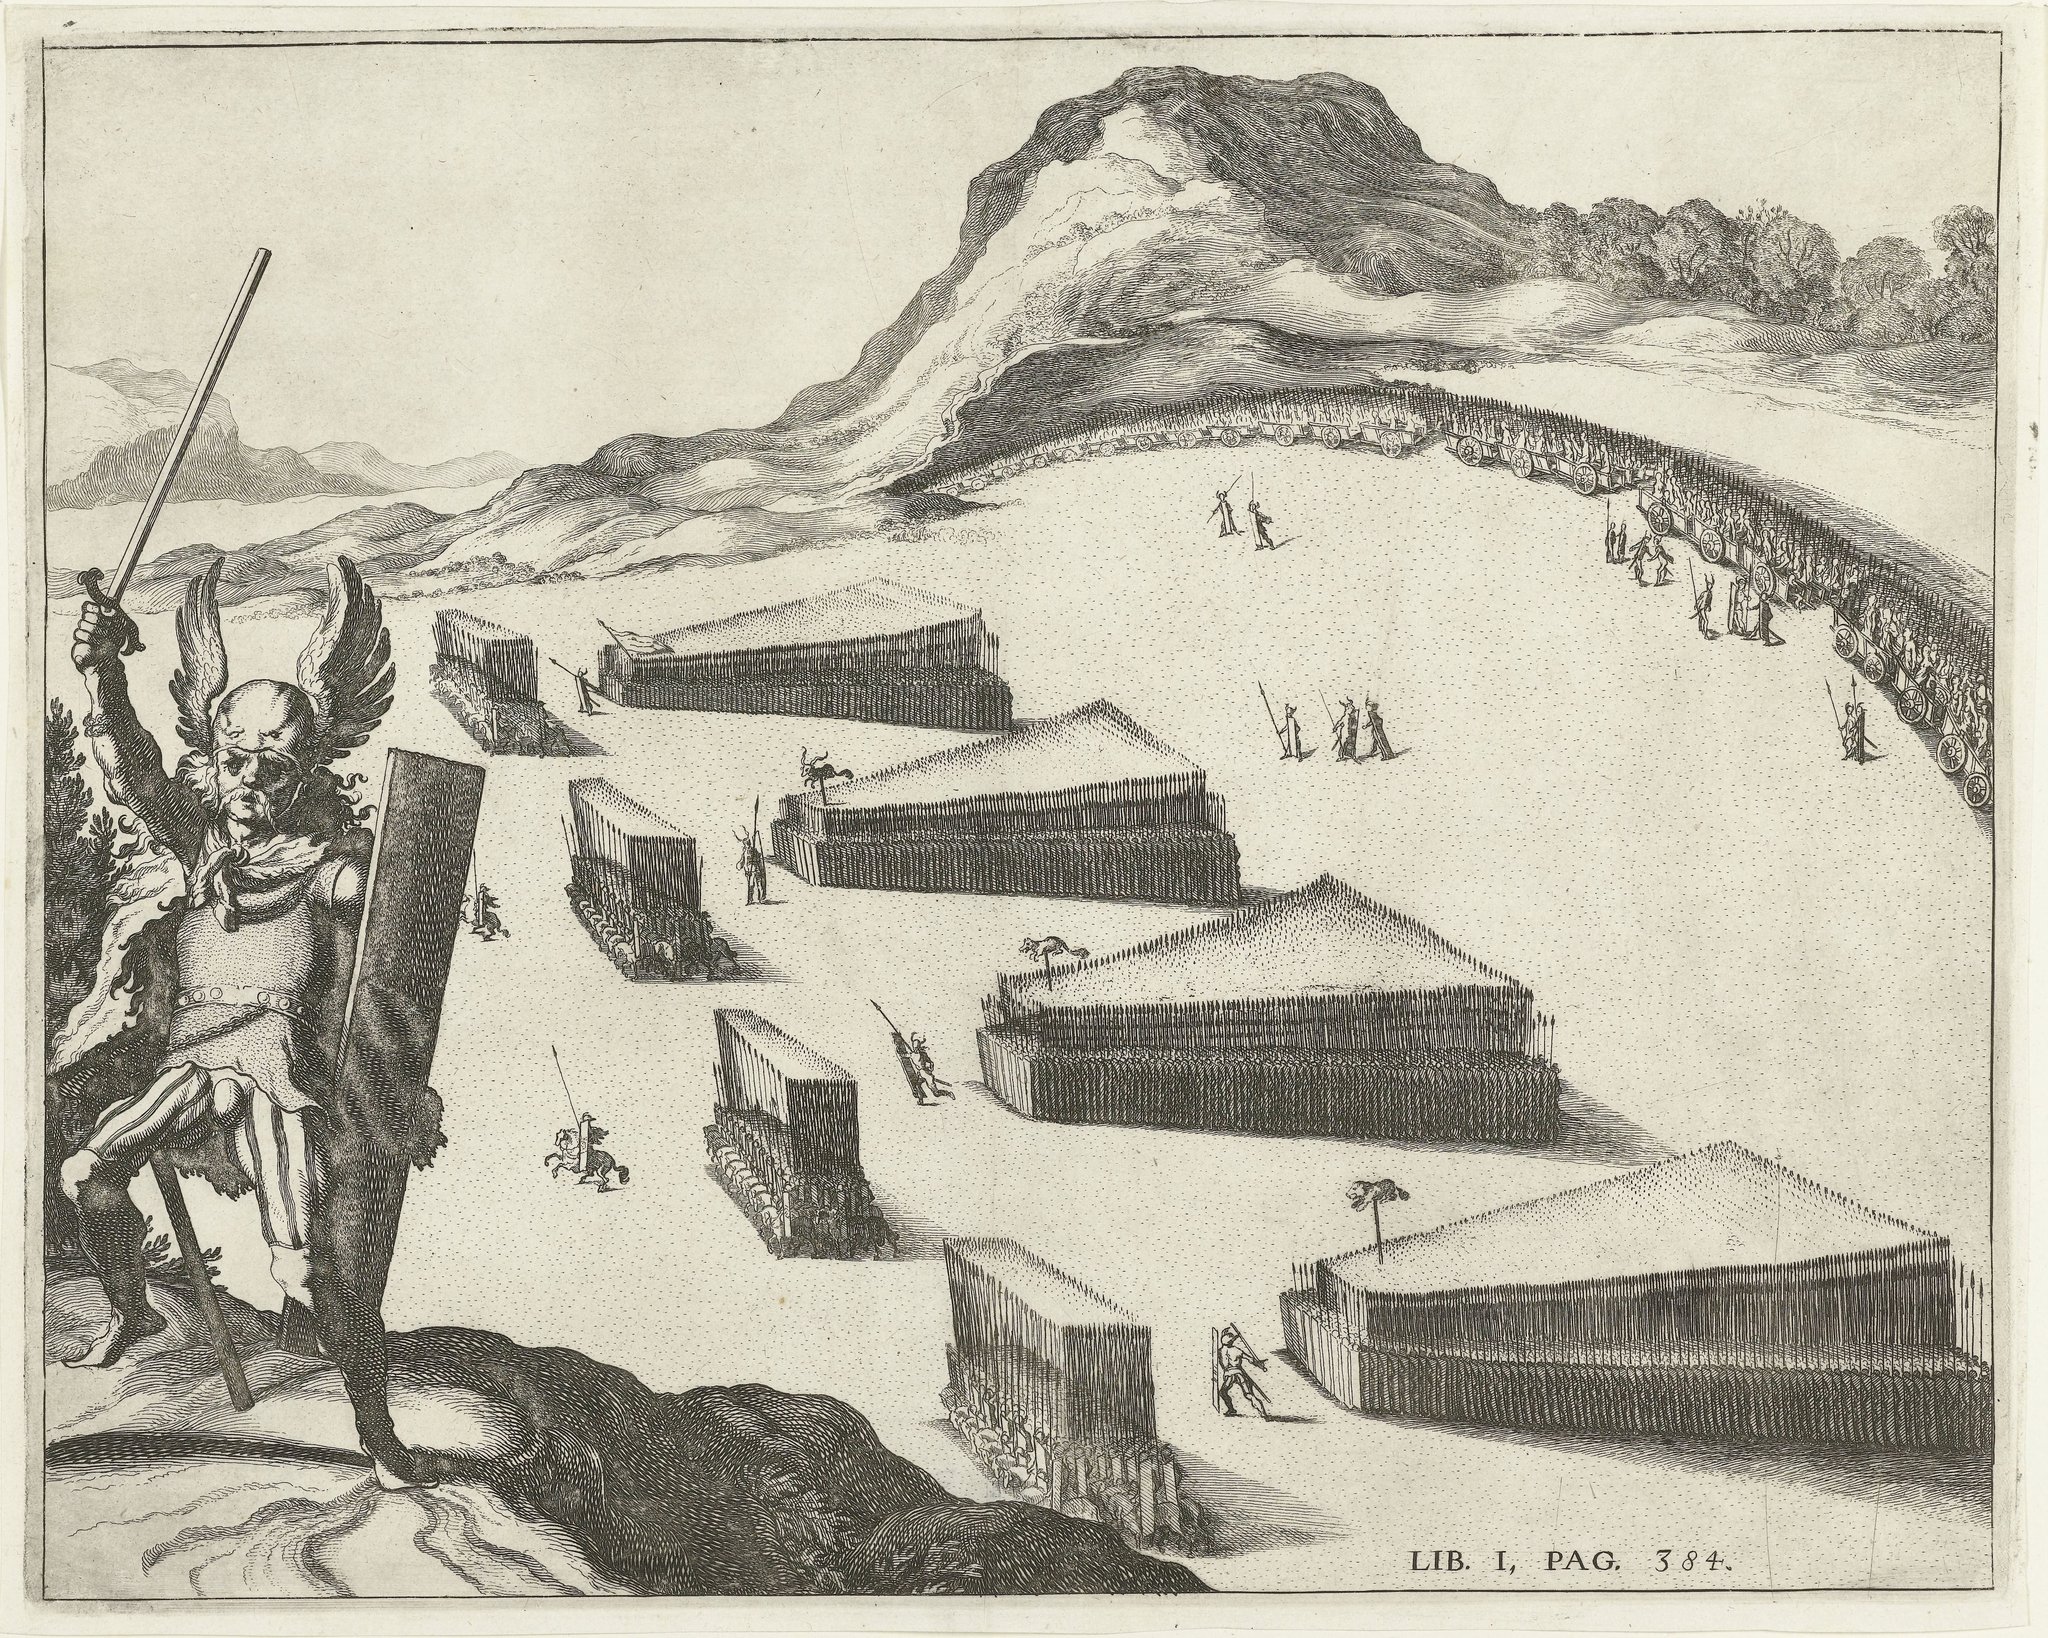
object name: print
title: Germaanse legertroepen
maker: simon frisius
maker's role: print maker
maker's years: 1570-1628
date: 1616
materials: paper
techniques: etching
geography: northern netherlands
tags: extinct, 'historical' peoples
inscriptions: collector's mark: Lugt 2228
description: Soldaat met schild, helm met vleugels en geheven zwaard staat links op de voorgrond. Diverse legertroepen op de achtergrond in een berglandschap.